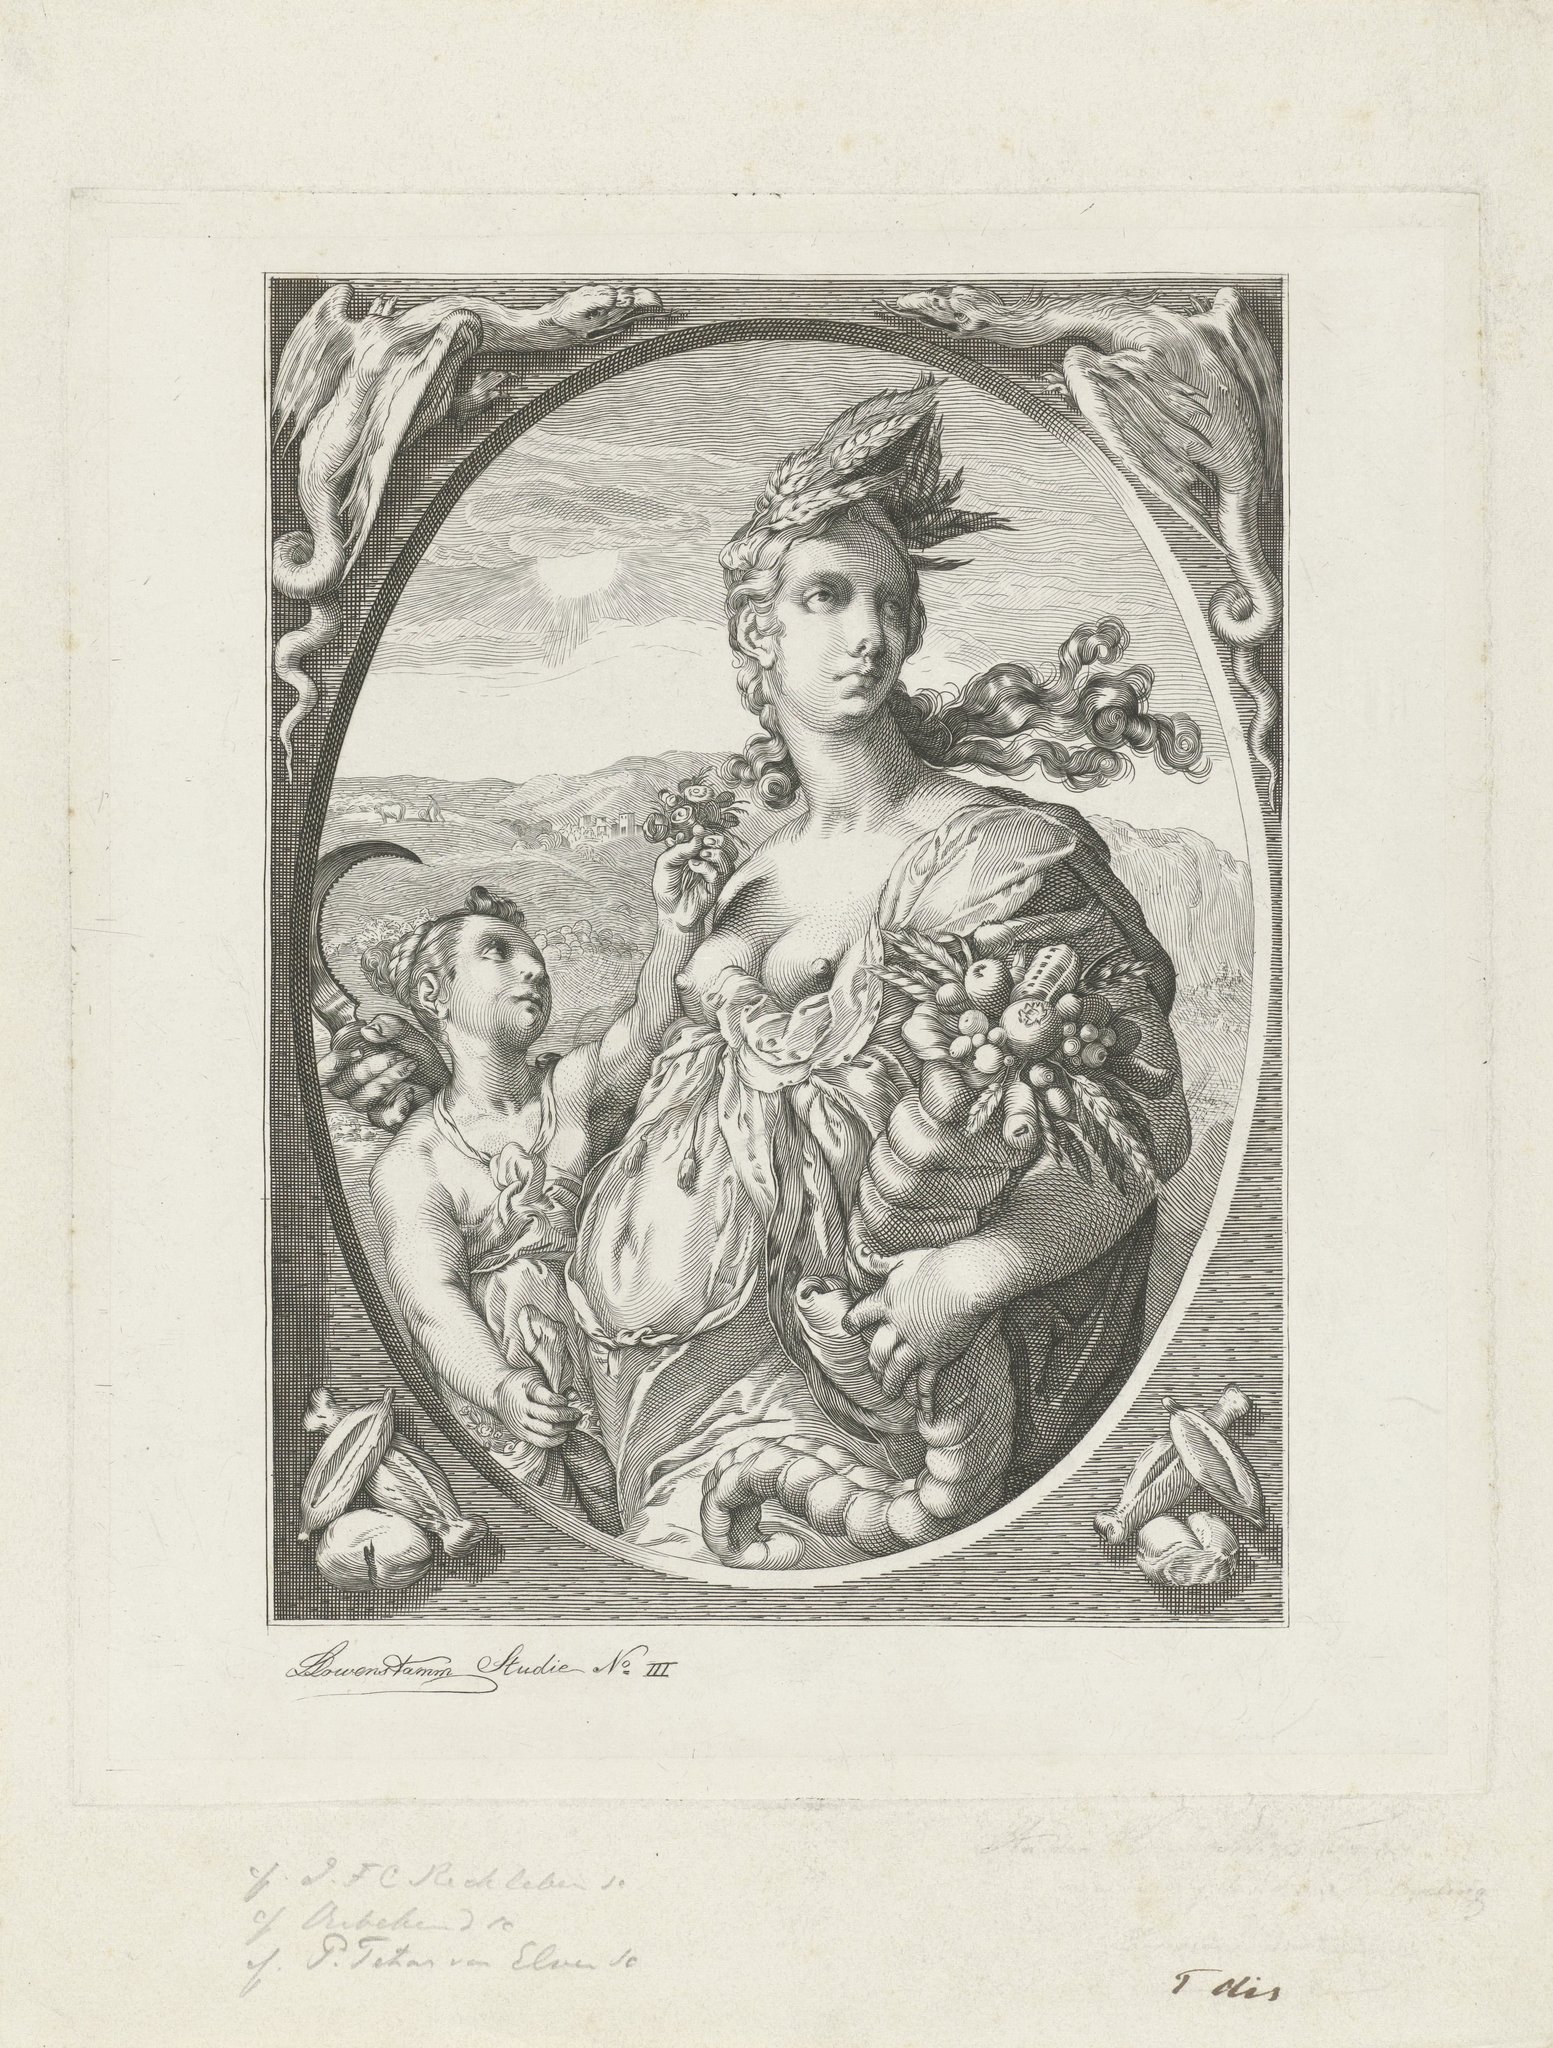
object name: print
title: Ceres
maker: leopold löwenstam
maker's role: print maker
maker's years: 1842-1898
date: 1852-1898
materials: paper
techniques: engraving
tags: (story of) ceres (demeter)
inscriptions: collector's mark: Lugt 2228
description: Ceres met een kroon van korenaren op het hoofd. In haar handen een sikkel en de hoorn des overvloeds. Naast Ceres een jongen met bloemen.